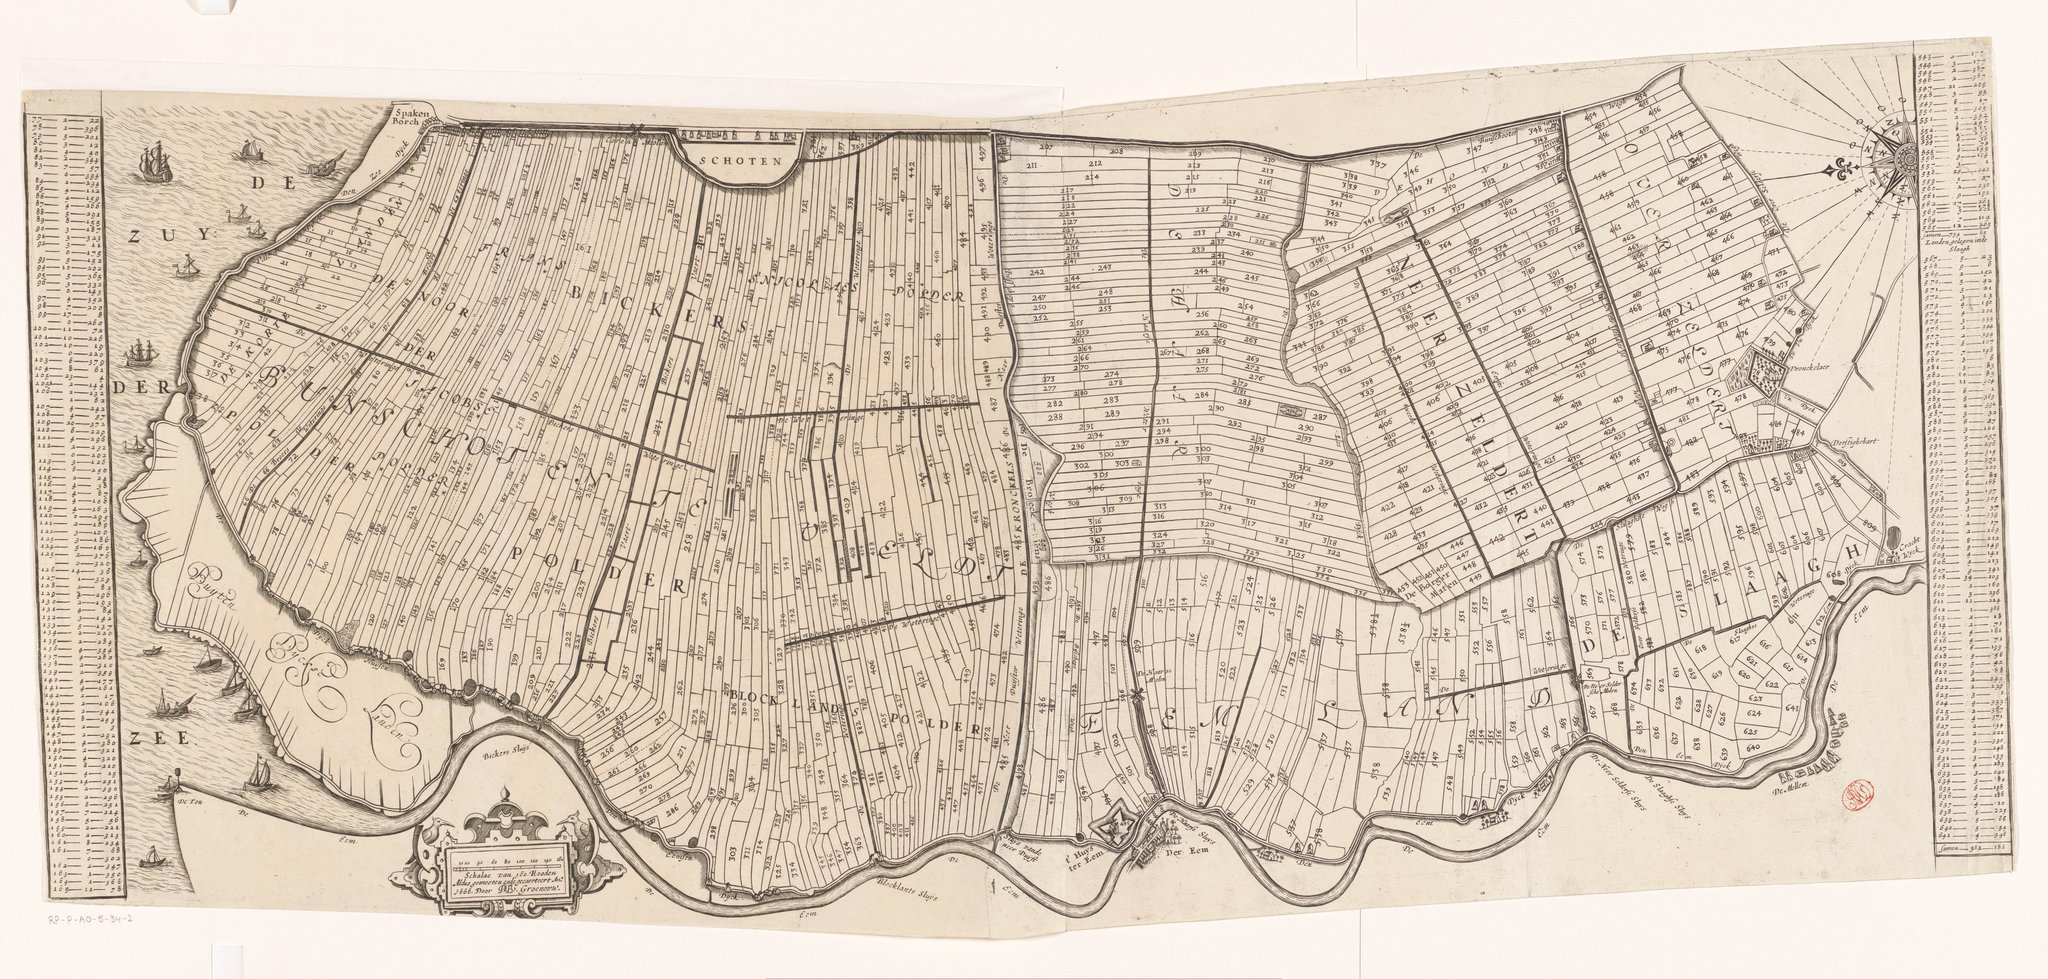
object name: map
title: Kaarte vande polders der Eemlandtsche leege landen etc. Ao. 1666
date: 1666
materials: paper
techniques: engraving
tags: maps of separate countries or regions, polder, reclaimed land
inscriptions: collector's mark: Lugt 195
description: Onderste deel van een polderkaart van Eemland.